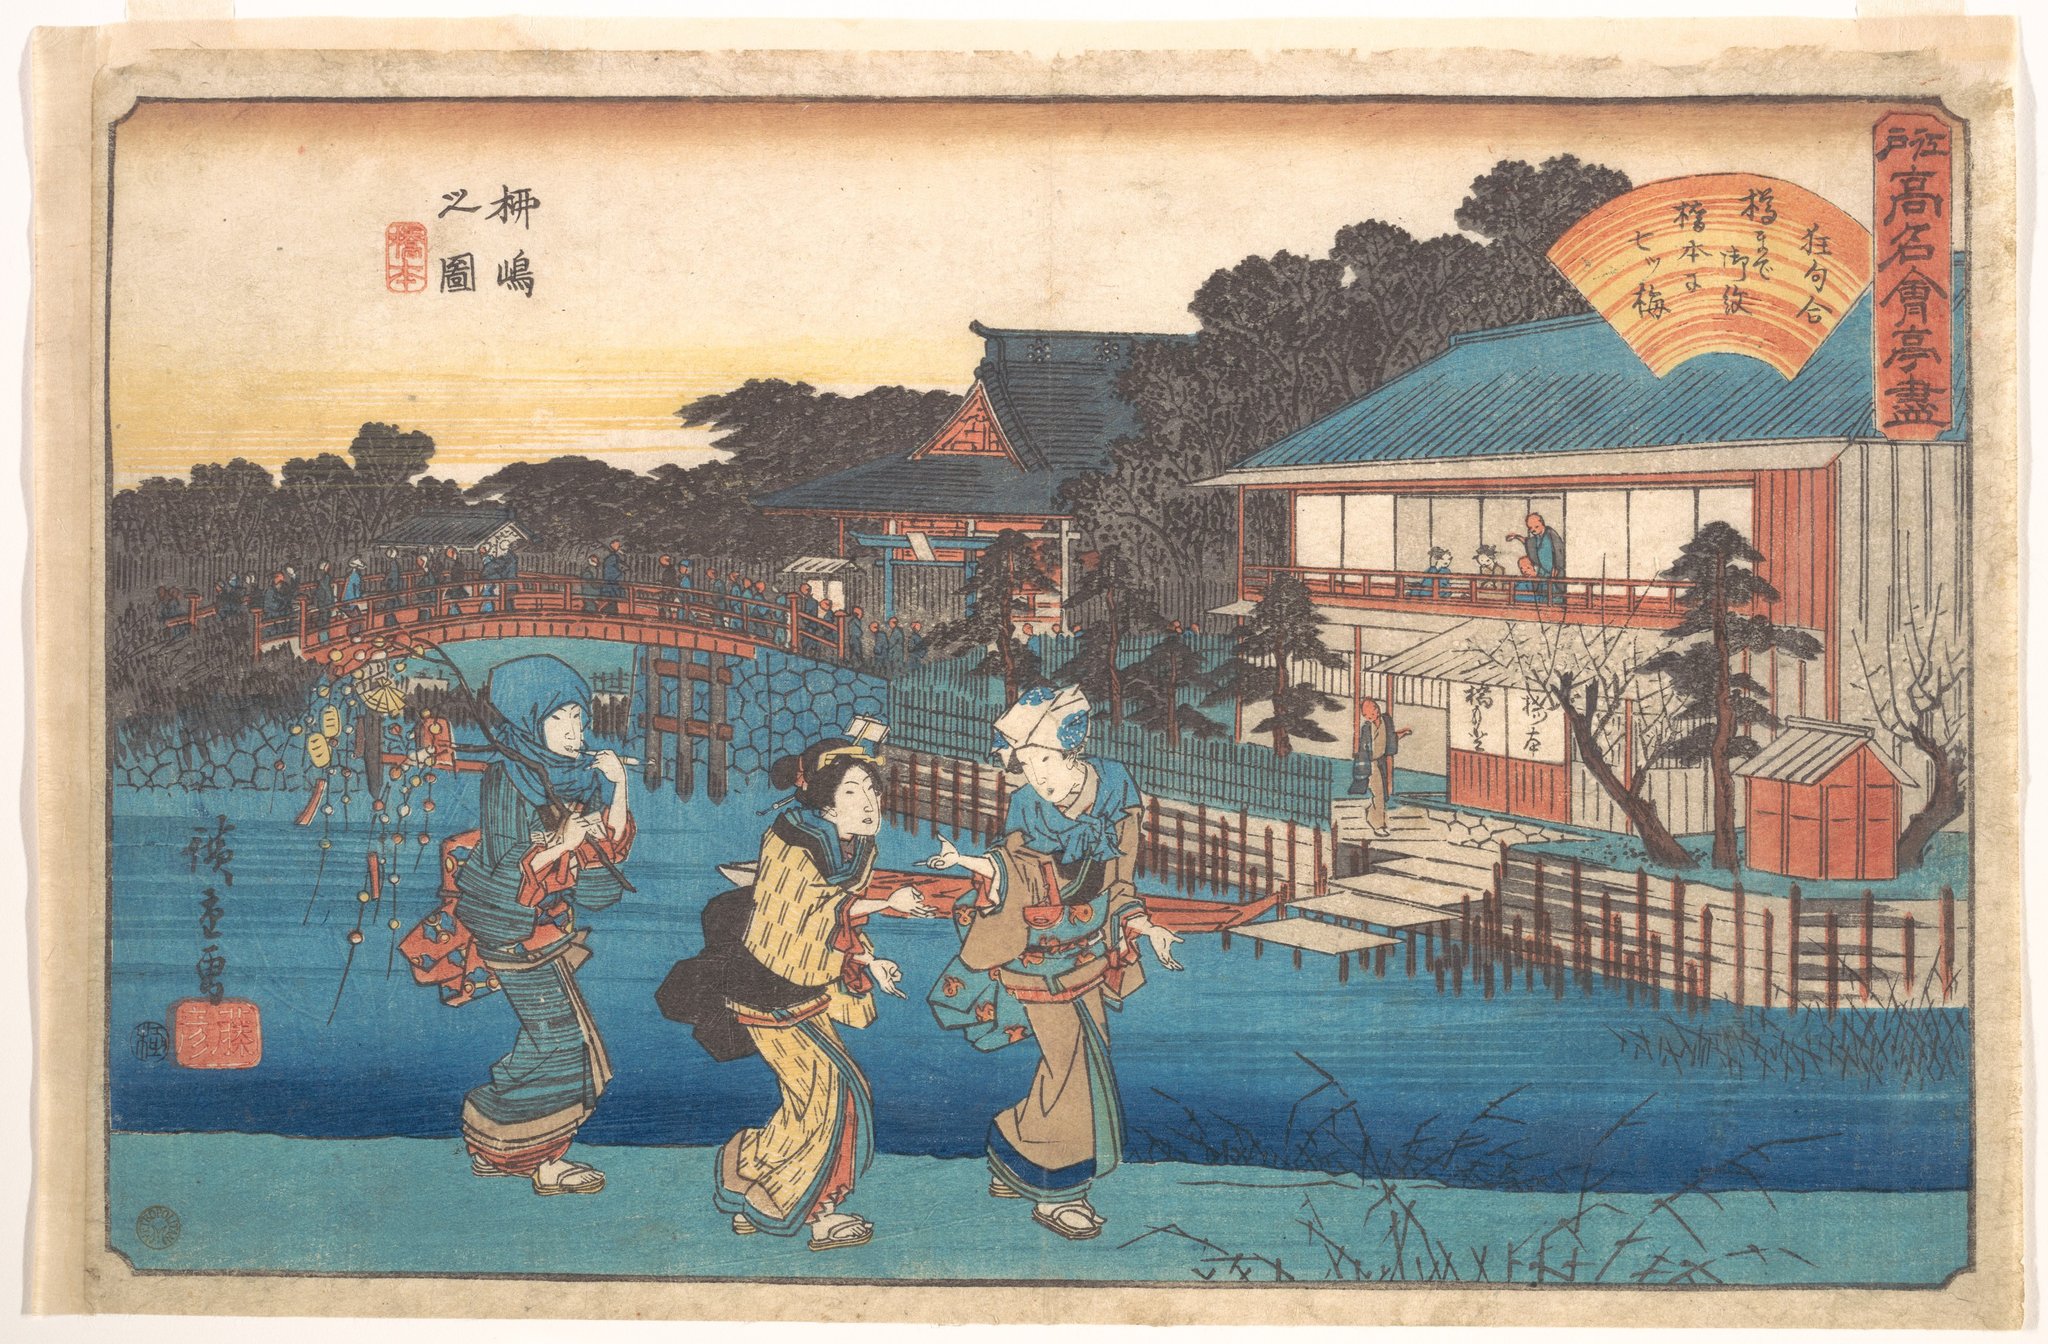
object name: print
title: Yanagishima no Zu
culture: japanese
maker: utagawa hiroshige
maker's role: artist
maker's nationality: japanese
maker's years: 1797-1858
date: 1835-1842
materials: ink, paper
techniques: woodblock print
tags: bridges,women,tea houses